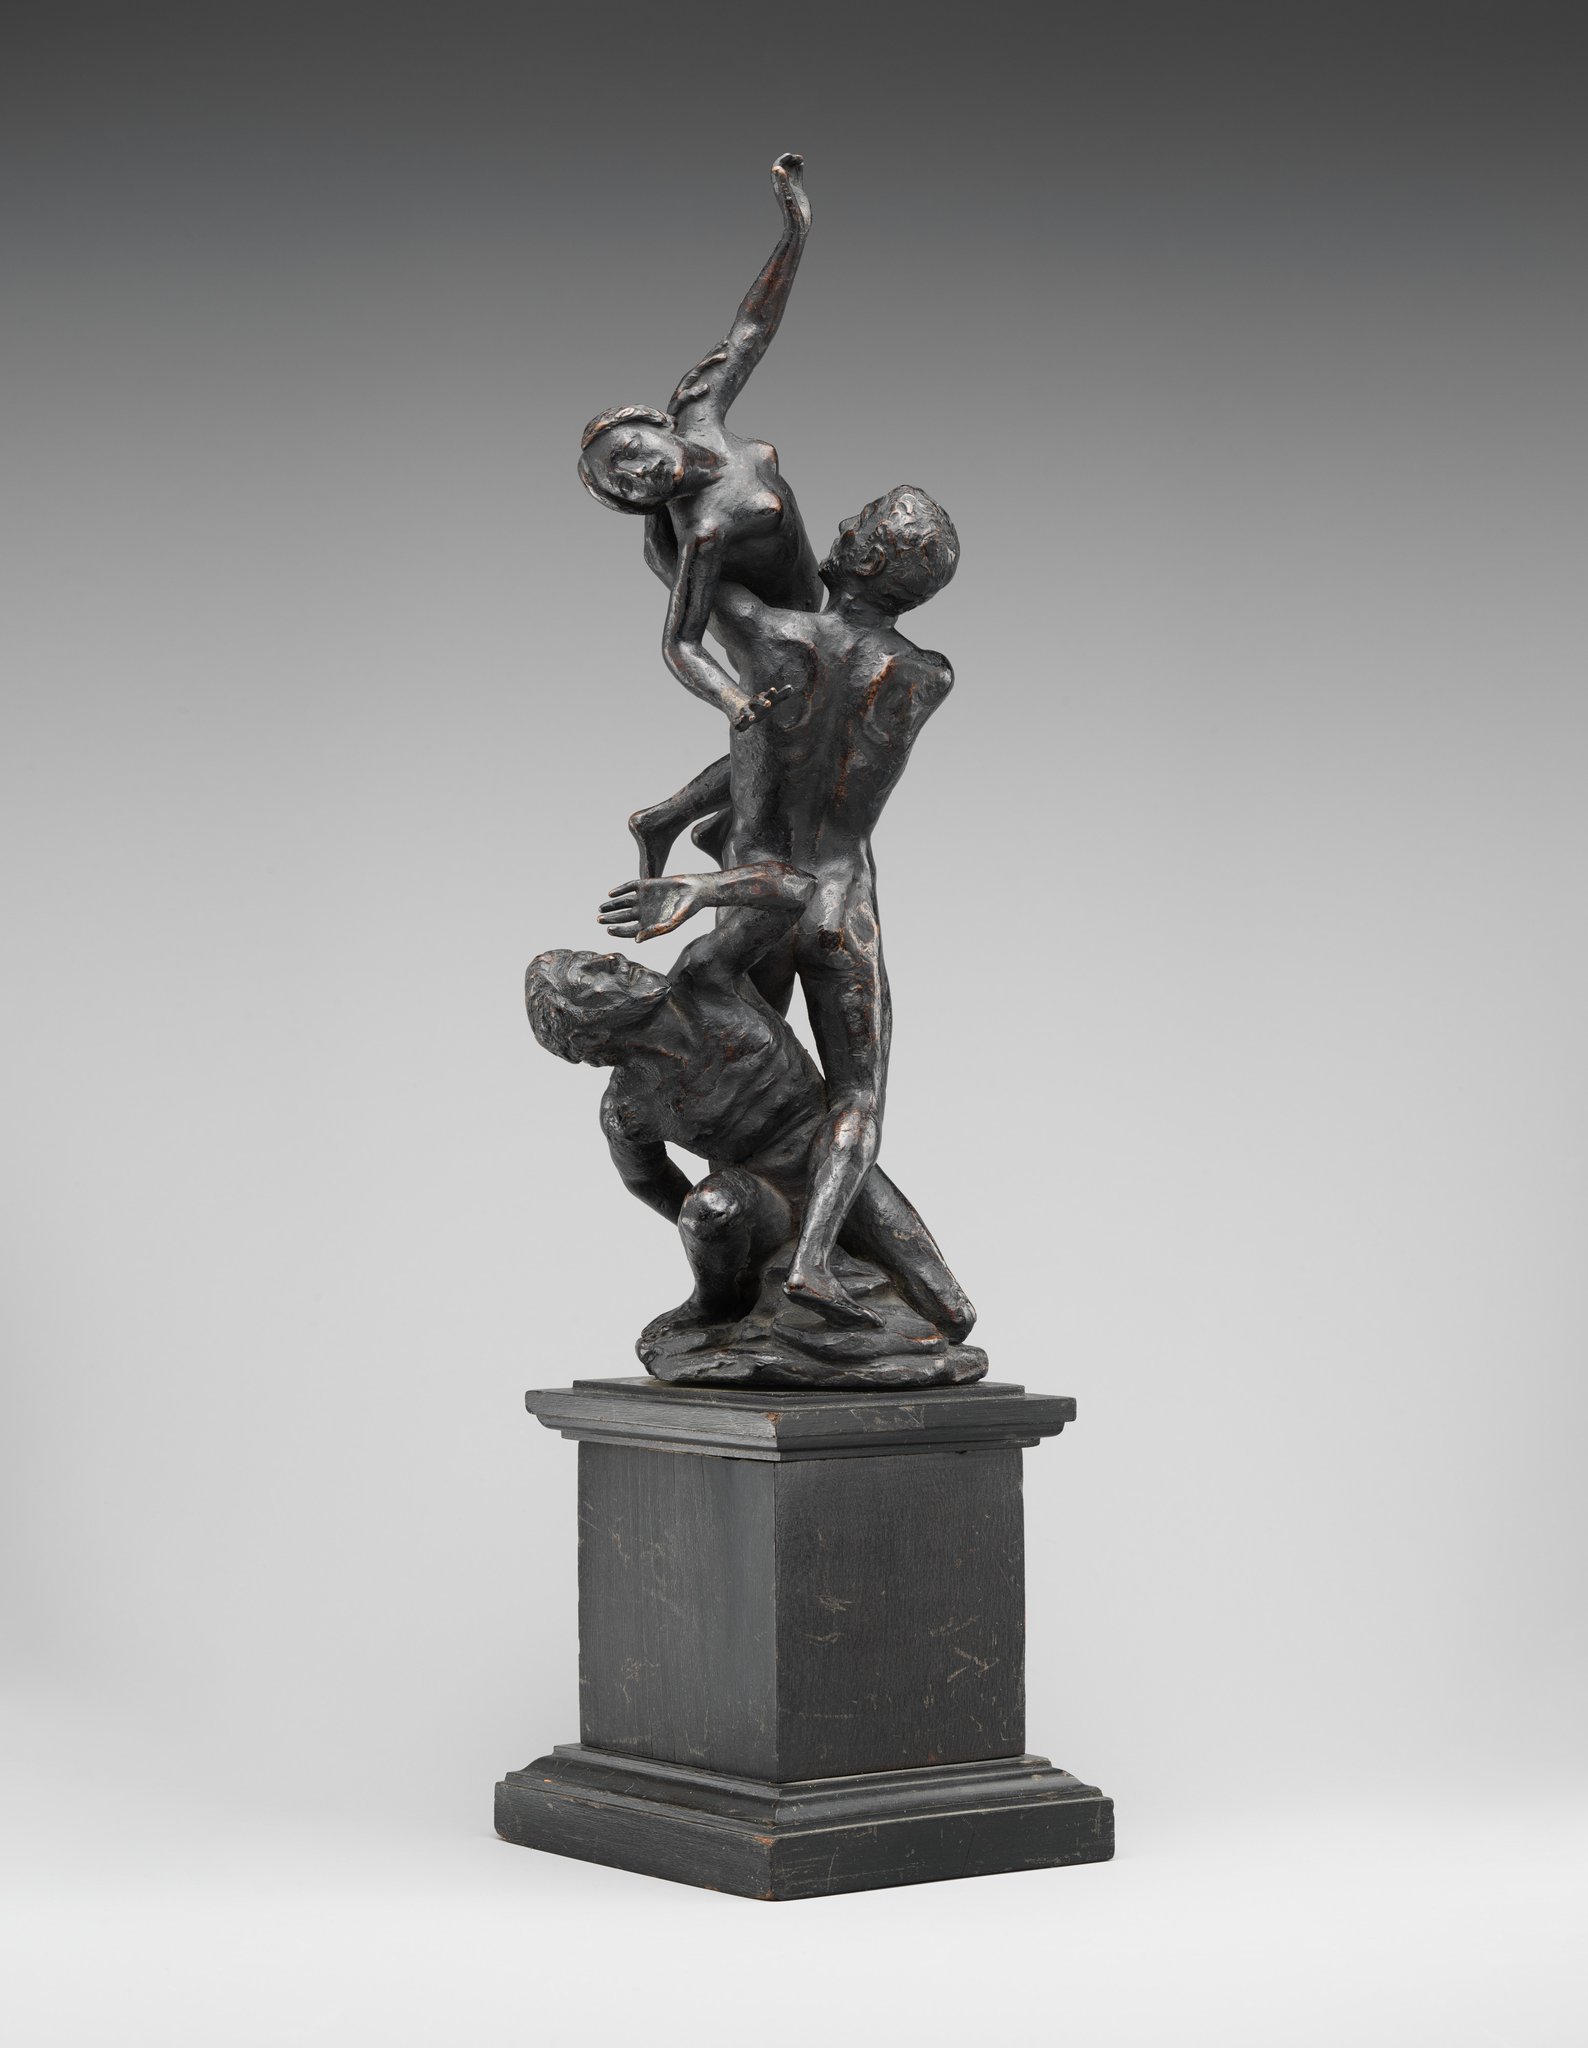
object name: statuette group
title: Abduction of a Sabine Woman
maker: giambologna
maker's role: artist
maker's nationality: netherlandish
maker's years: 1529-1608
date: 1601-1633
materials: bronze, wood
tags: male nudes,female nudes